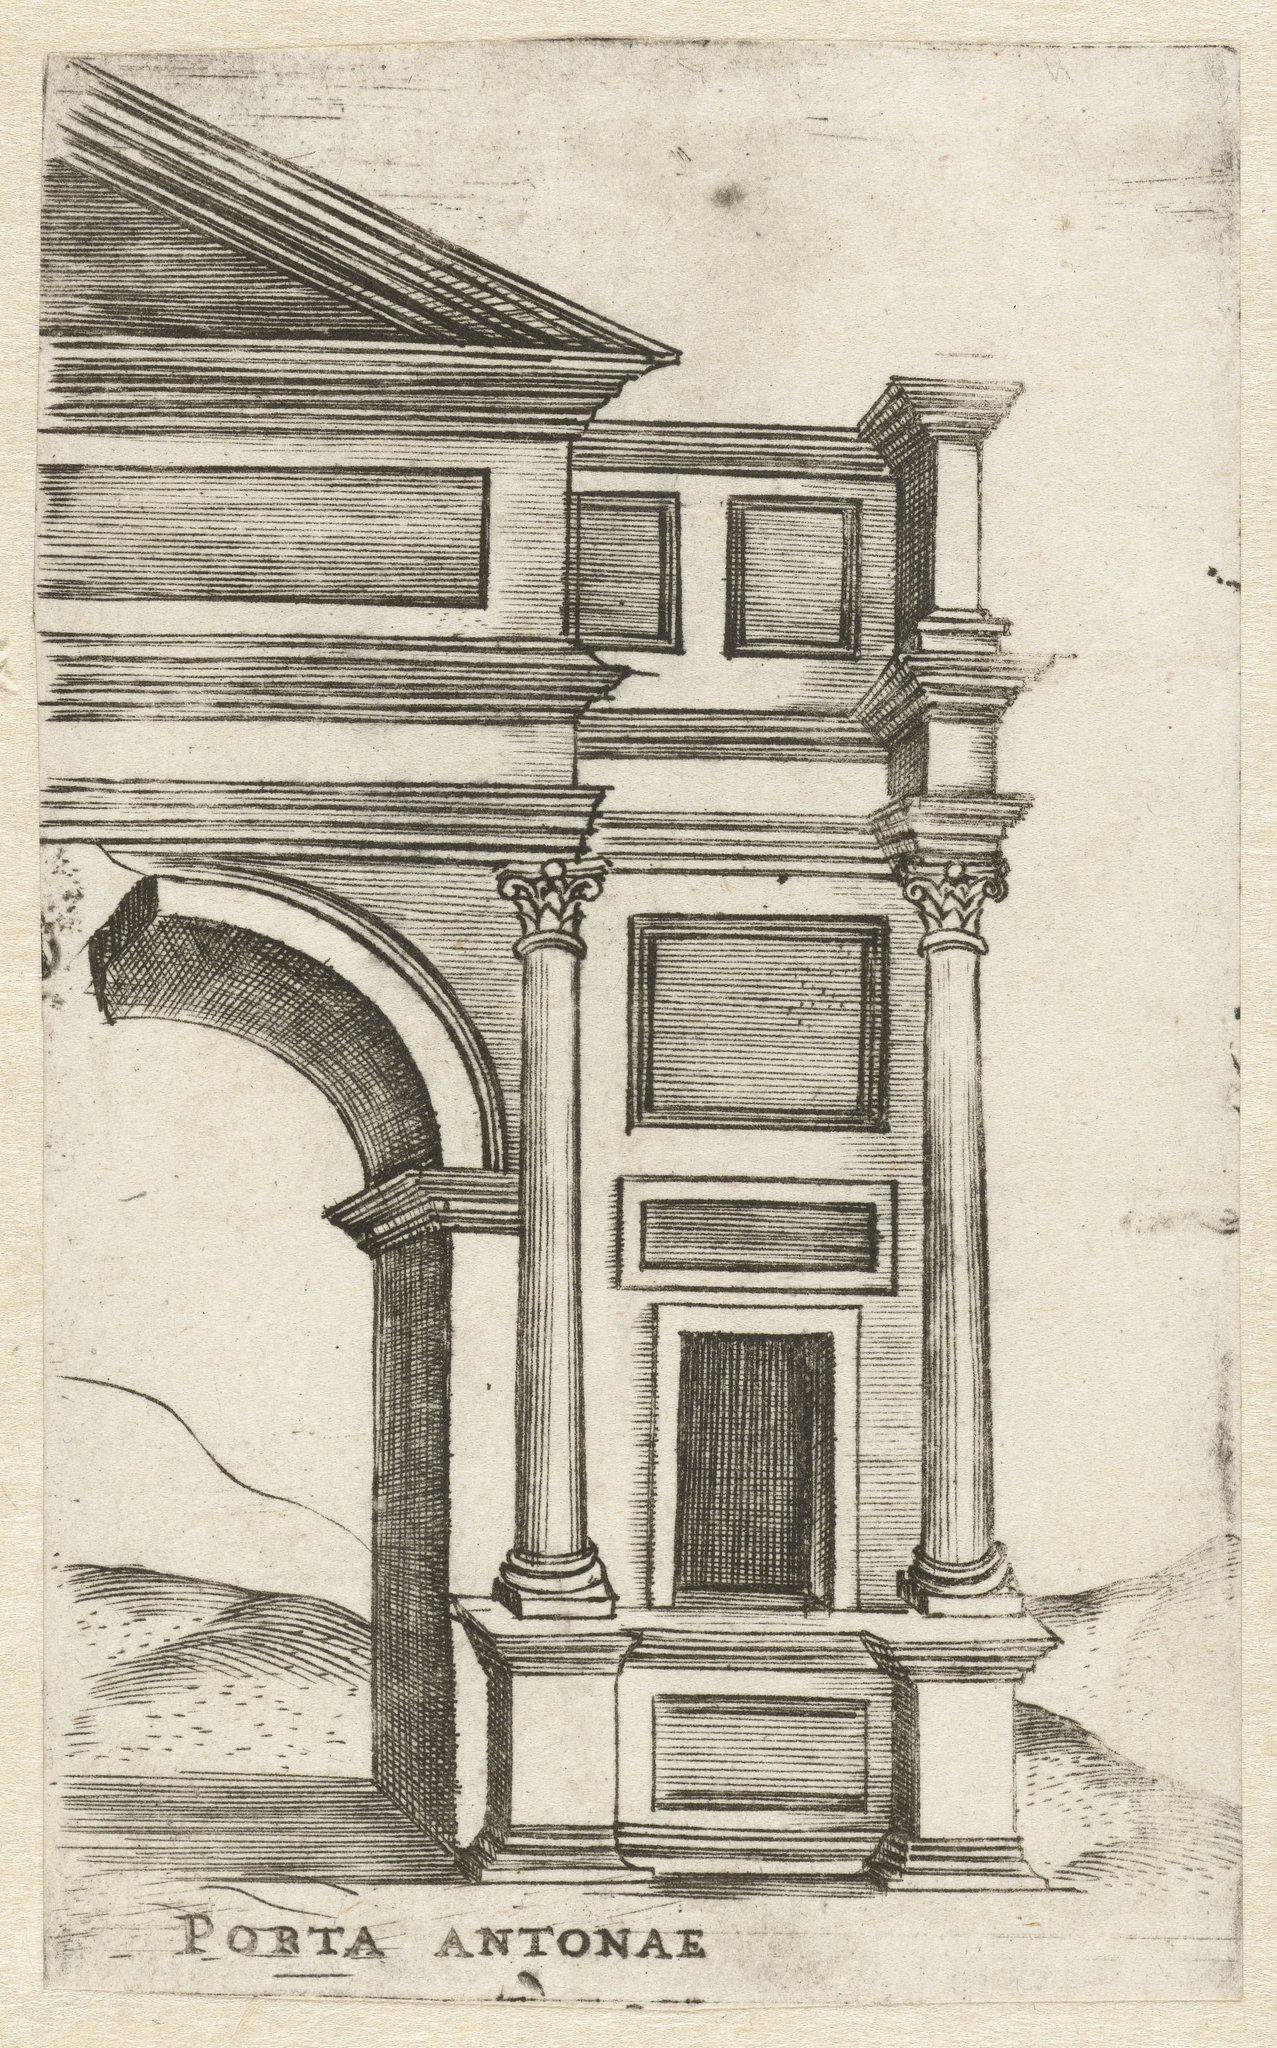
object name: print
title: Porta antonae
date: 1500-1549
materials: paper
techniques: engraving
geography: italy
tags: triumphal arch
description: Deel van een klassieke triomfboog of poort die, blijkens het Latijnse onderschrift, ter ere van Antona is opgericht: een doorgang en twee zuilen onder een architraaf waarop een timpaan rust. Deze prent is onderdeel van een serie prenten van antieke gebouwen.